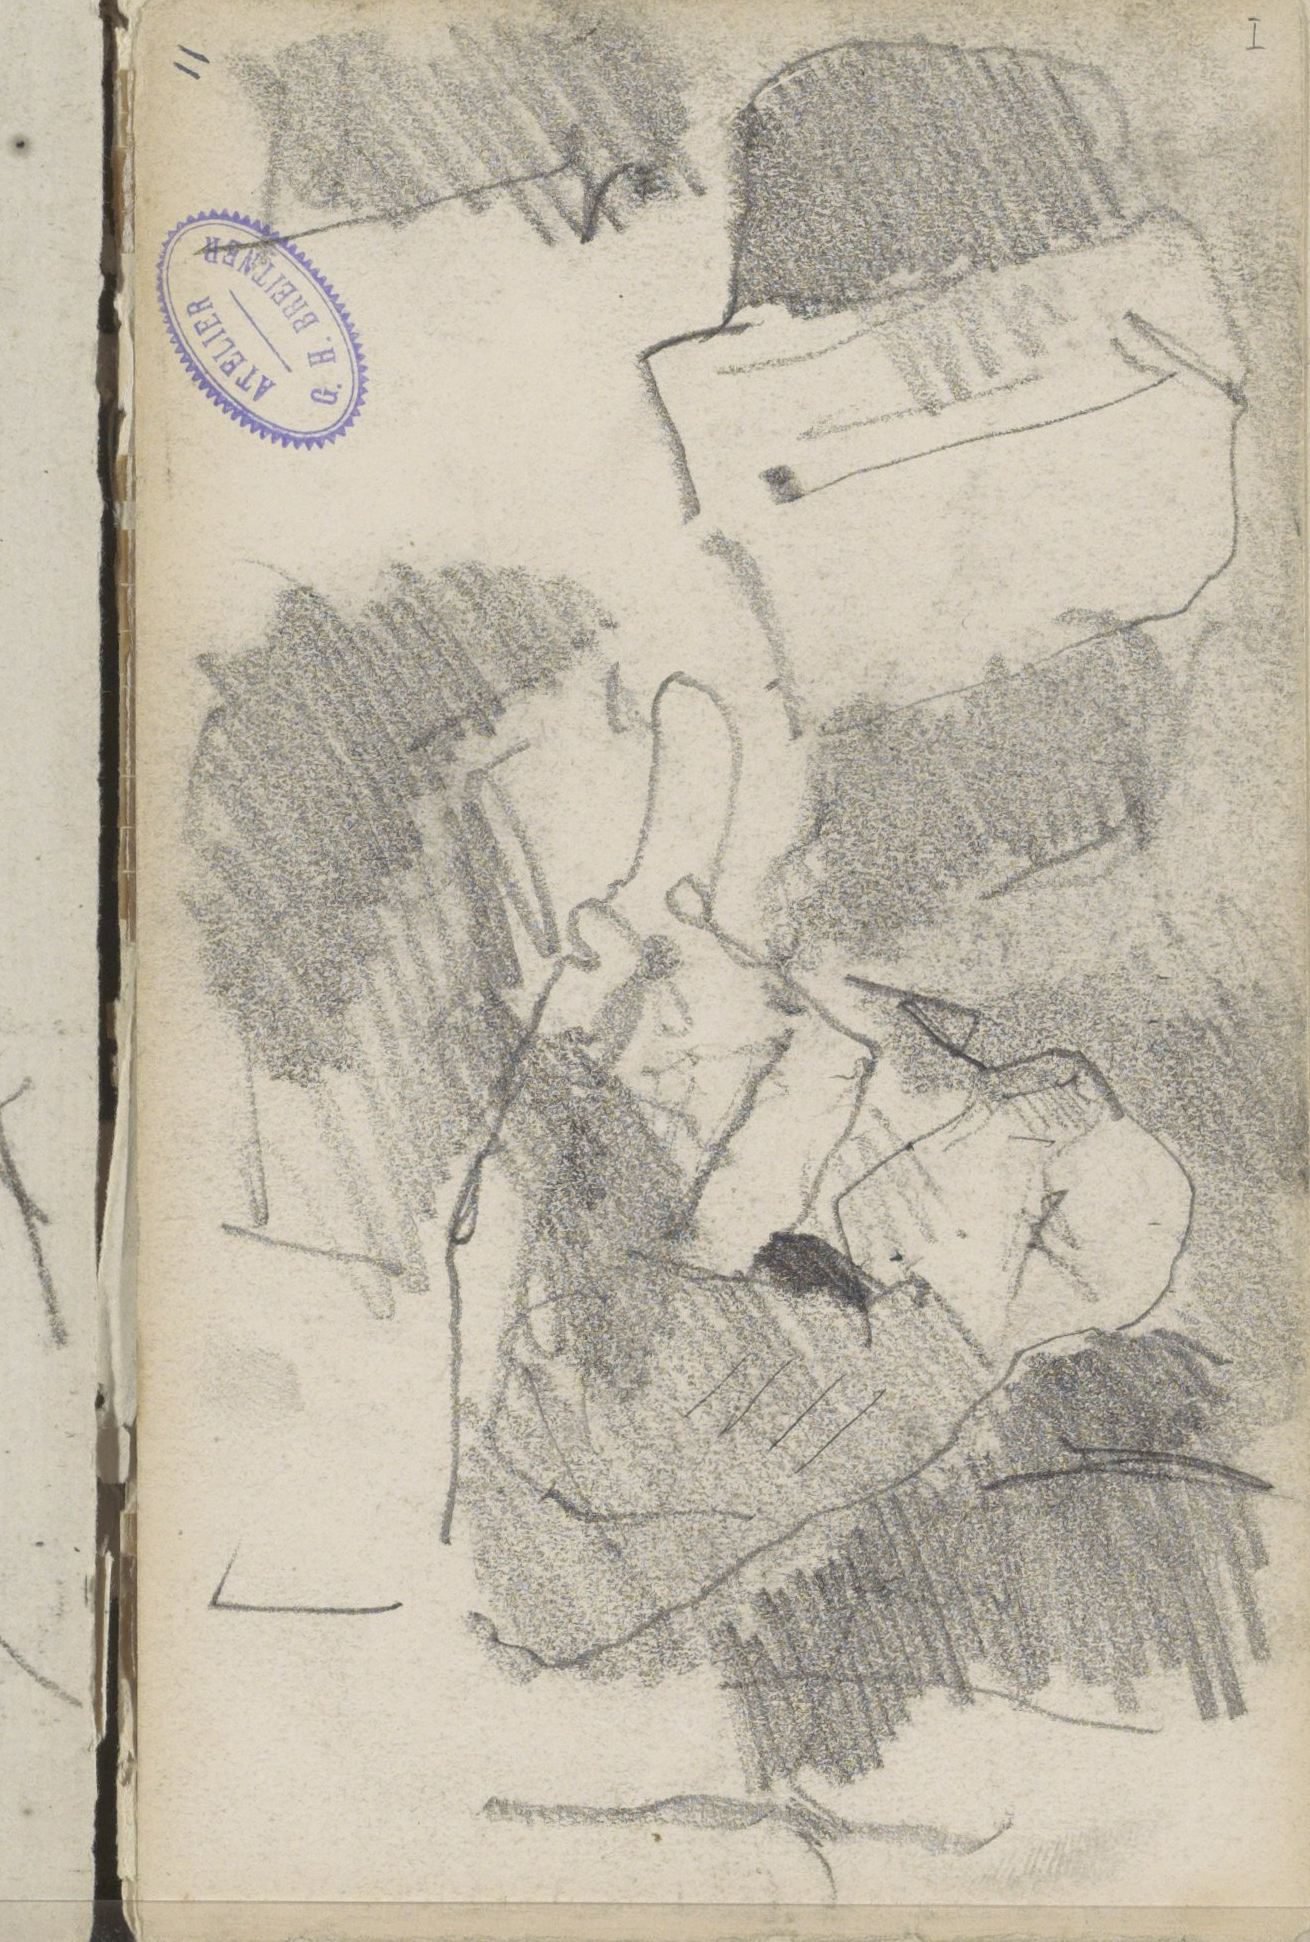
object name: sketchbook leaf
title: Lezende man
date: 1880-1882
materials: paper, pencil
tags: reading, adult man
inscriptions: workshop stamp: Lugt 291d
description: Los blad recto aangetroffen tussen blad 9 en blad 11 in een schetsboek met 16 bladen.